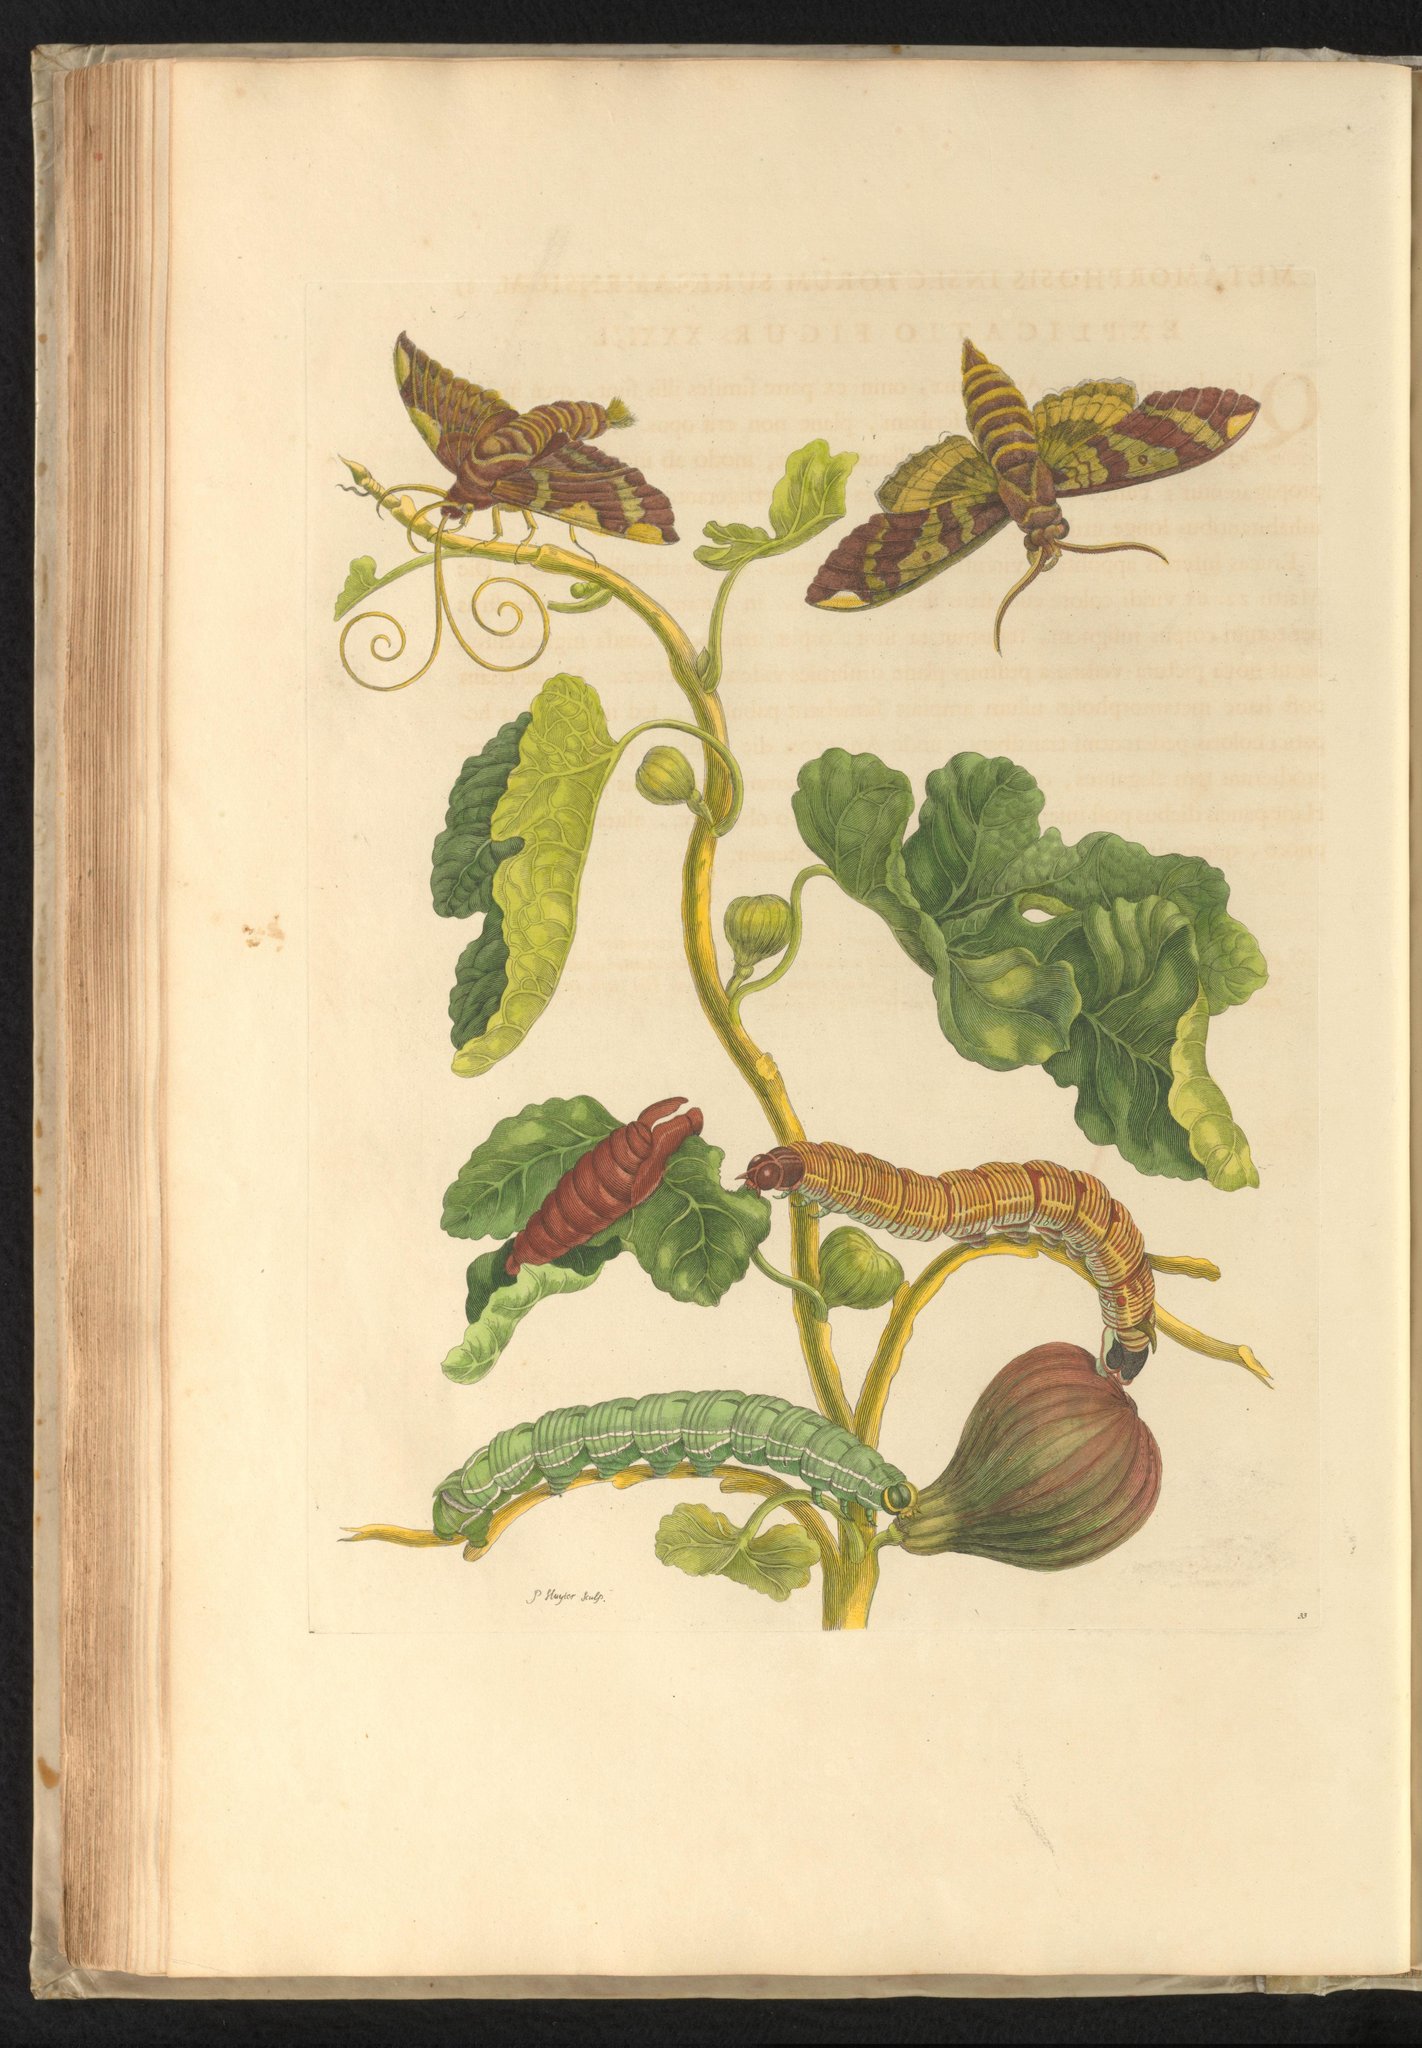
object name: page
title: Vijgenboom (Ficus carica) met twee nachtvlinders, twee rupsen en een pop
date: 1705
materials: paper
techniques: etching, hand coloring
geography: suriname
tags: insects: pupa, trees: fig-tree, insects: moth, insects: caterpillar, suriname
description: Rechtsonder genummerd: 33. Prent maakt deel uit van een boek.